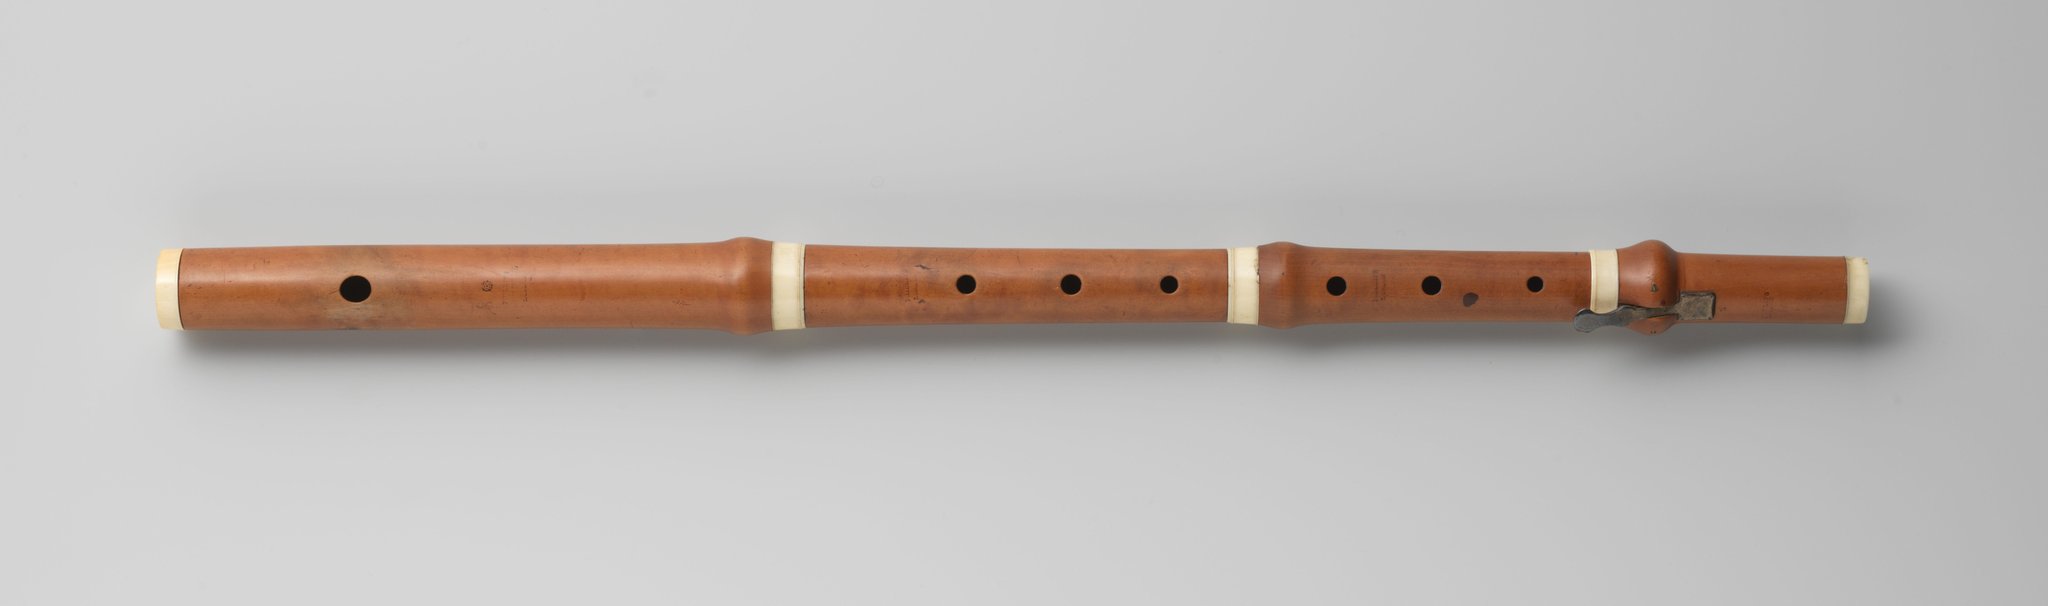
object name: transverse flute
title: Flute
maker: philips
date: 1802-1827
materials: wood, brass, ivory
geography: london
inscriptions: : ‘'(rose) / PHILLIP’S / LITTLE TOWER HILL / LONDON'.’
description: Gaaf geconserveerde, uitstekend speelbare vierdelige dwarsfluit van buxushout met ringen van ivoor en een messing klep; stemming ca. a-440 Hz. Met maar één klep is het voor de tijd van ontstaan een conservatief gebouwd instrument. Stempel: '(rose) / PHILLIP’S / LITTLE TOWER HILL / LONDON'.